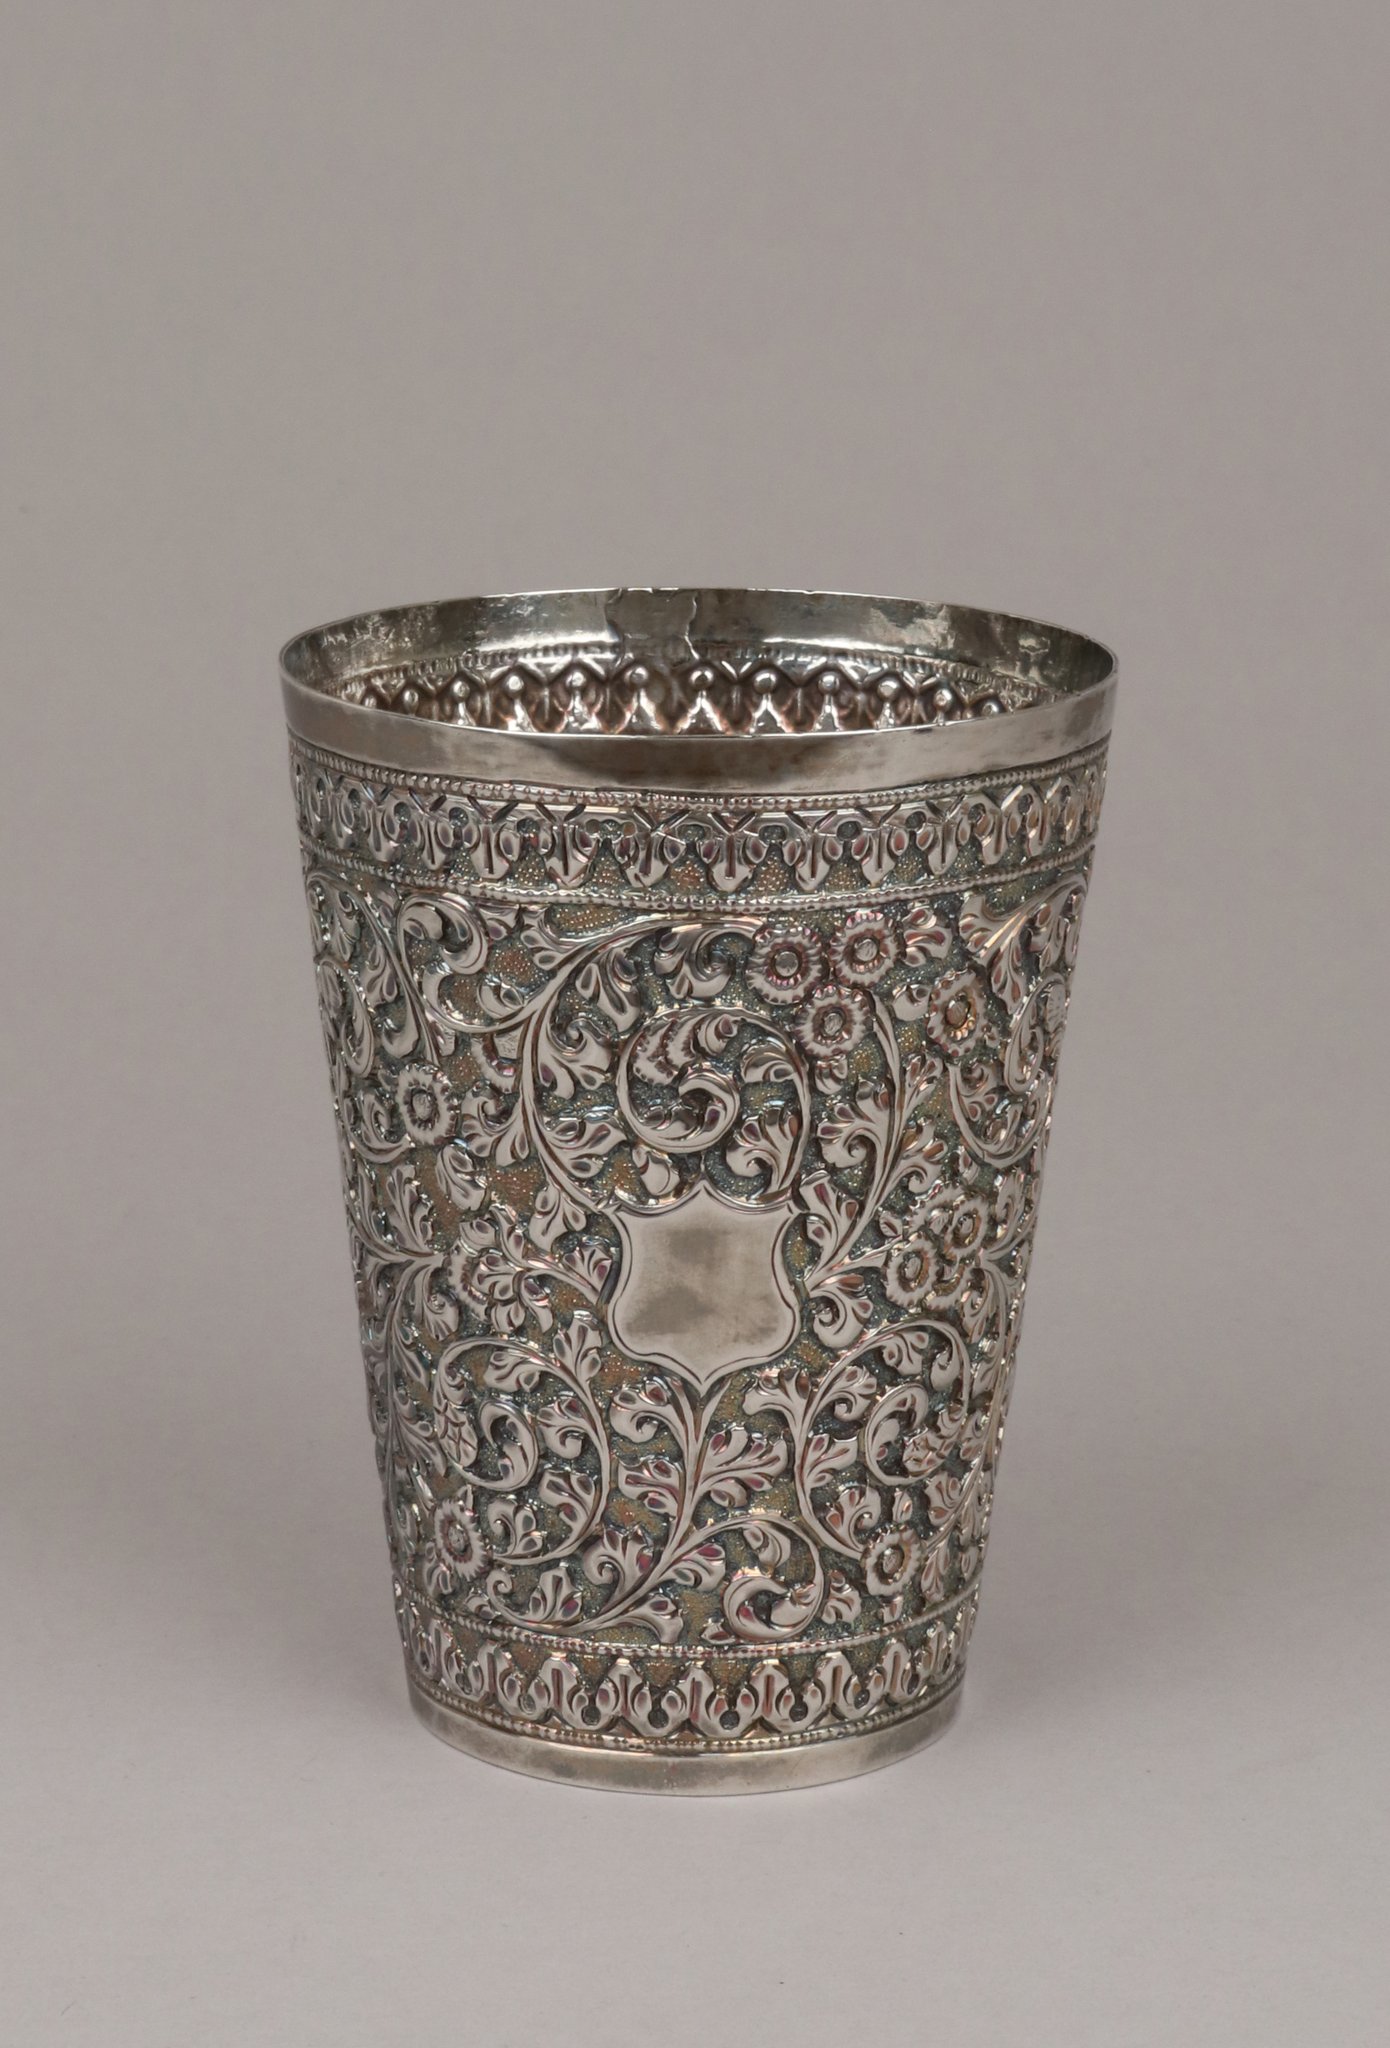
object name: beaker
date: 1767-1900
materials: silver